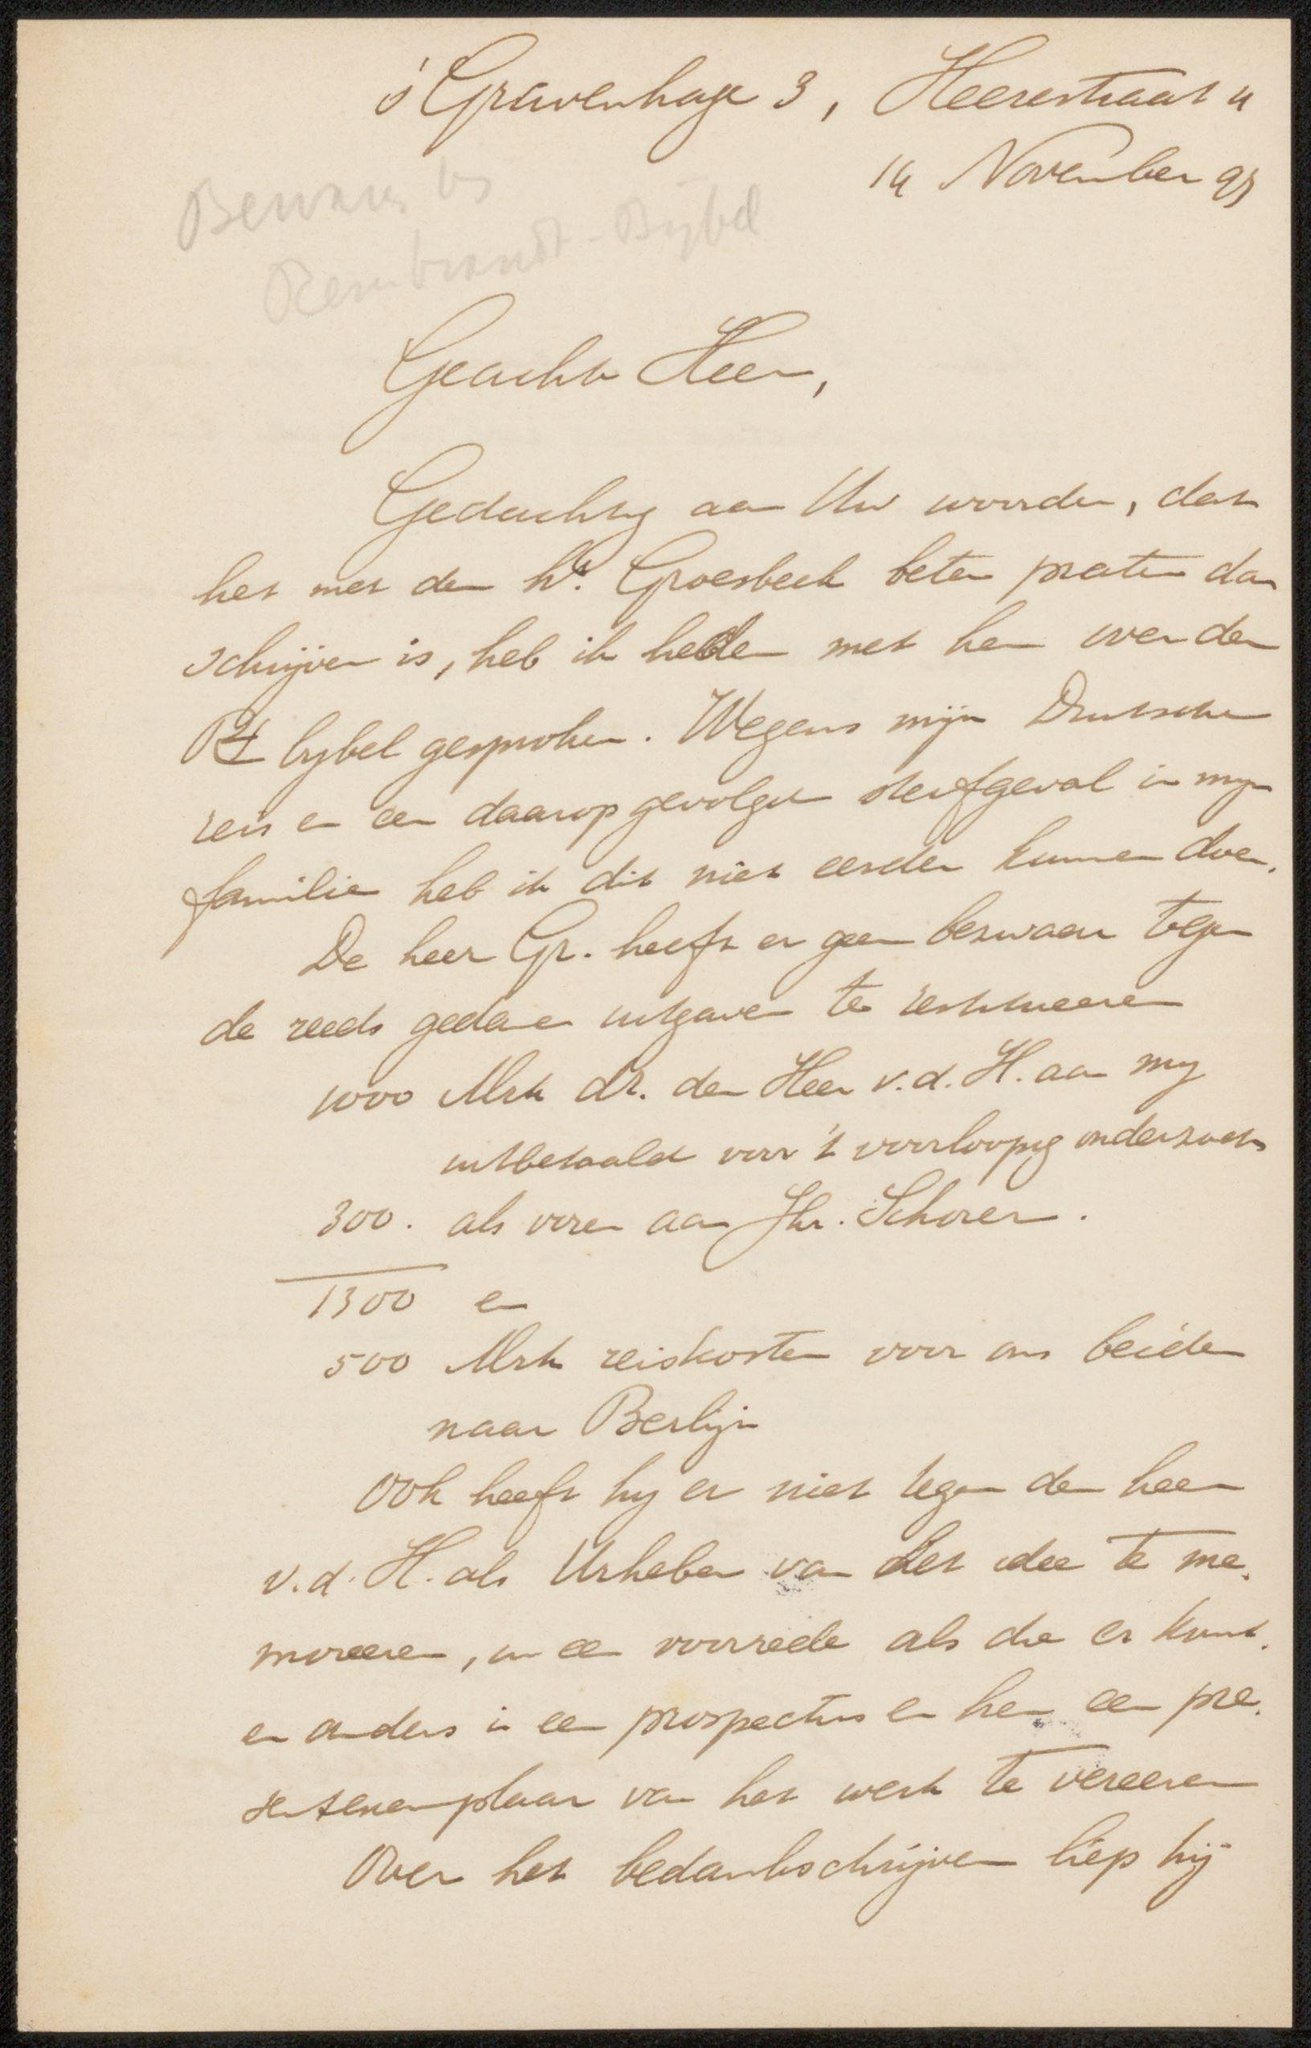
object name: letter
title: Brief aan Jan Veth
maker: cornelis hofstede de groot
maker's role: kunsthistoricus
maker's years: 1863-1940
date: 1897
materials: ink, paper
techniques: pen, writing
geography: the hague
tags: dordrecht, painter, print maker, draughtsman, designer, jan veth, leiden, rembrandt van rijn, klaas groesbeek, money, berlin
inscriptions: collector's mark: ‘RPK’